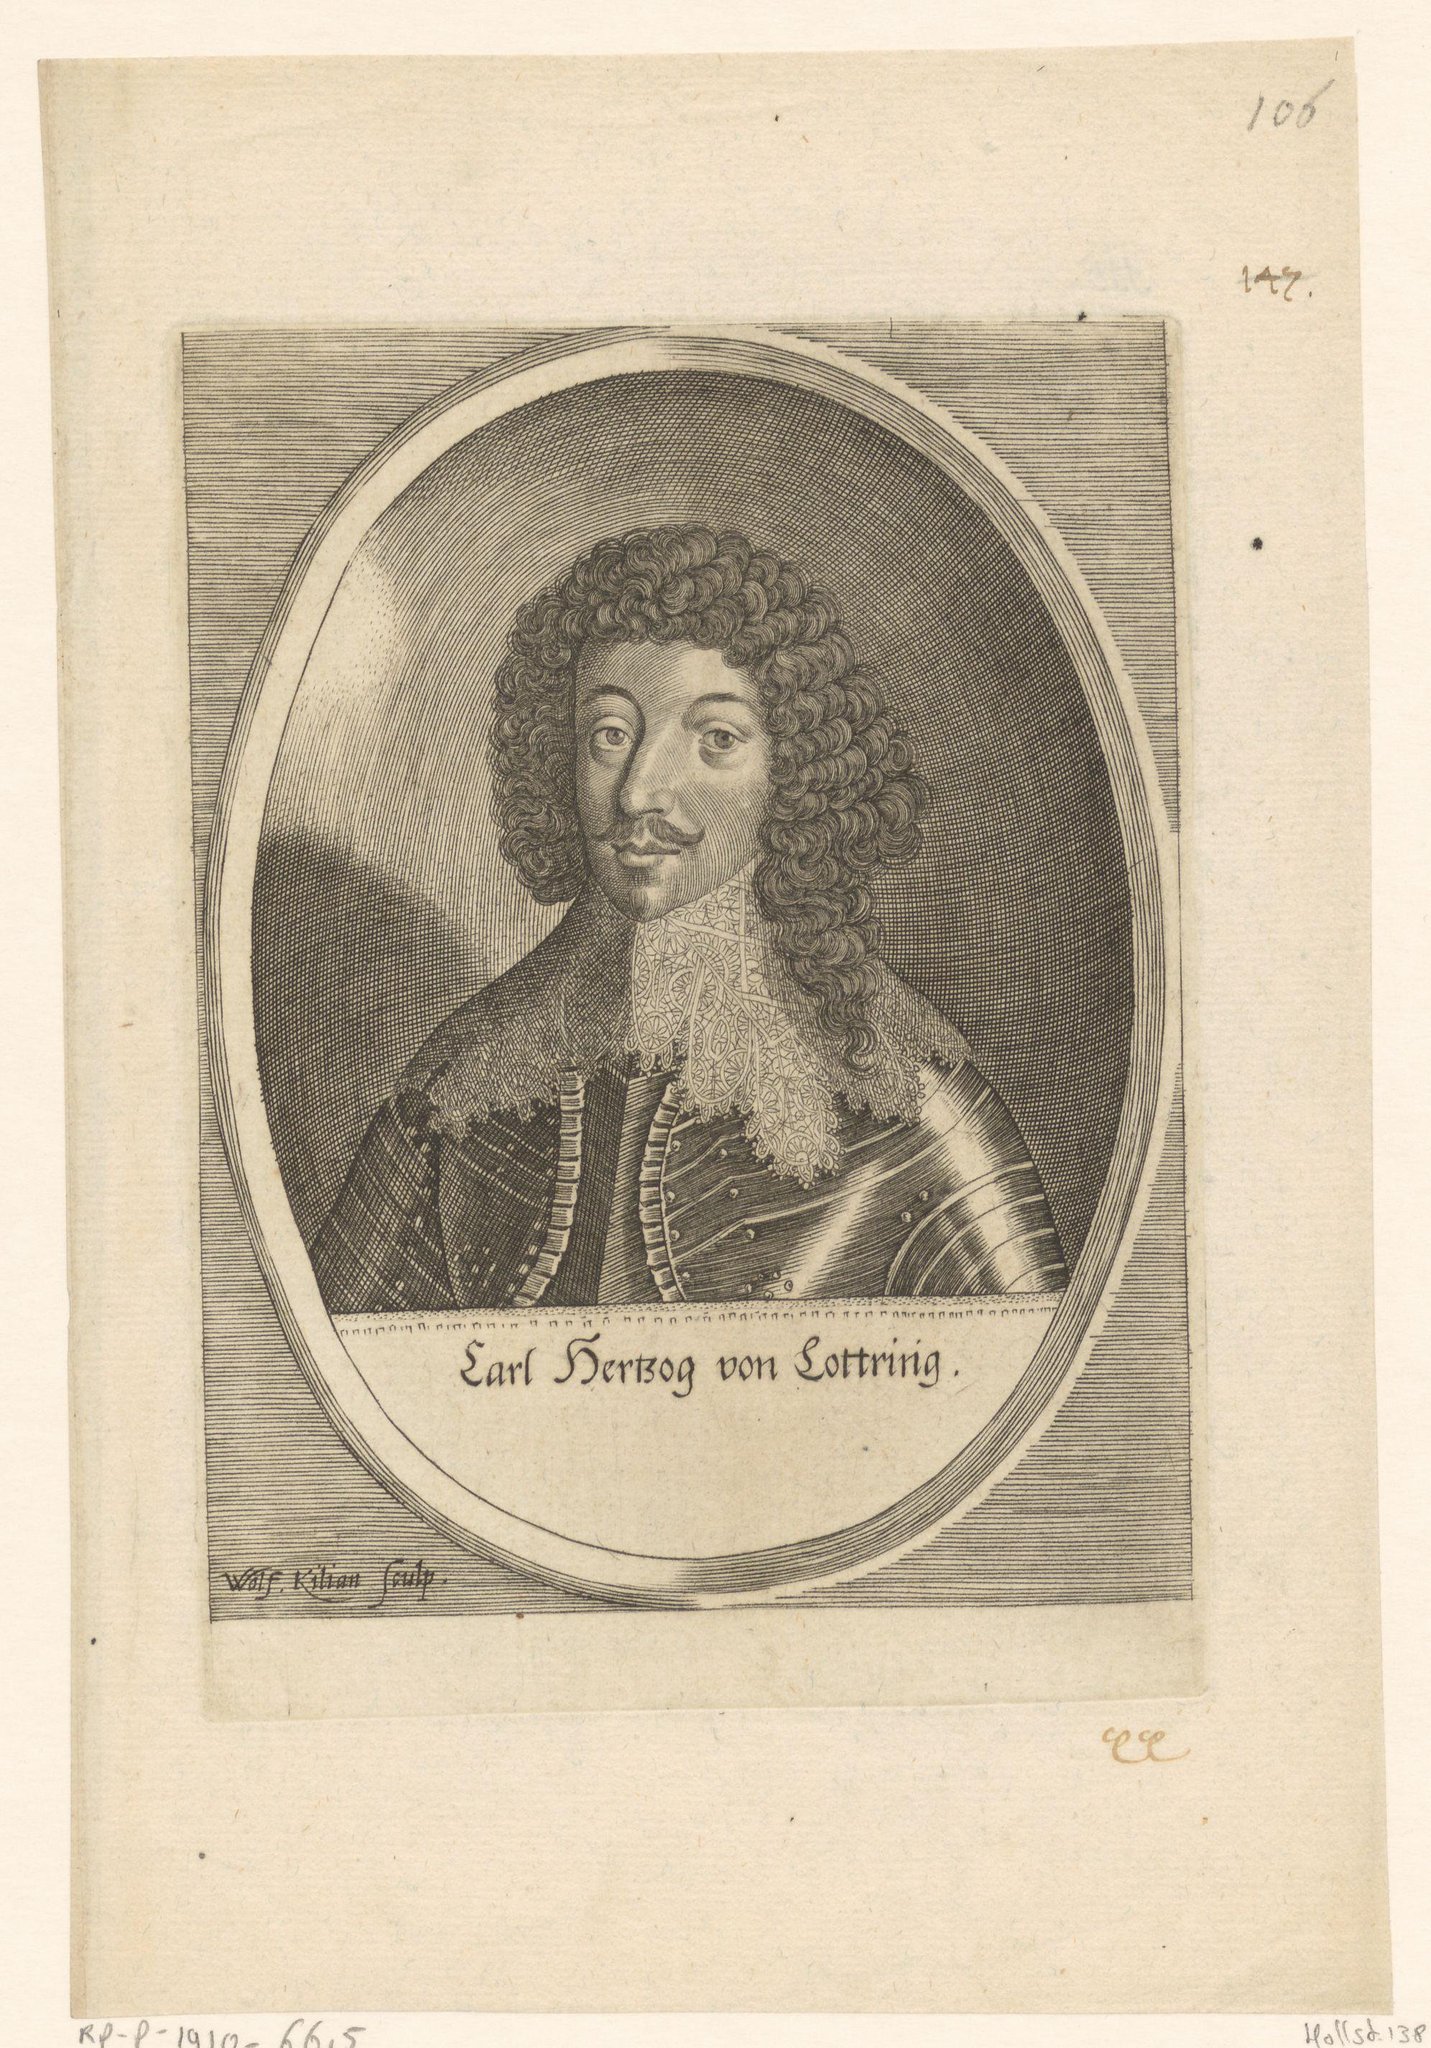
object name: print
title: Portret van Karl von Lotharingen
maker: wolfgang kilian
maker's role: print maker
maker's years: 1581-1662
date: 1591-1662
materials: paper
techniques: engraving, etching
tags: historical persons, regent, substitute ruler; viceroy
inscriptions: collector's mark: Lugt 2228